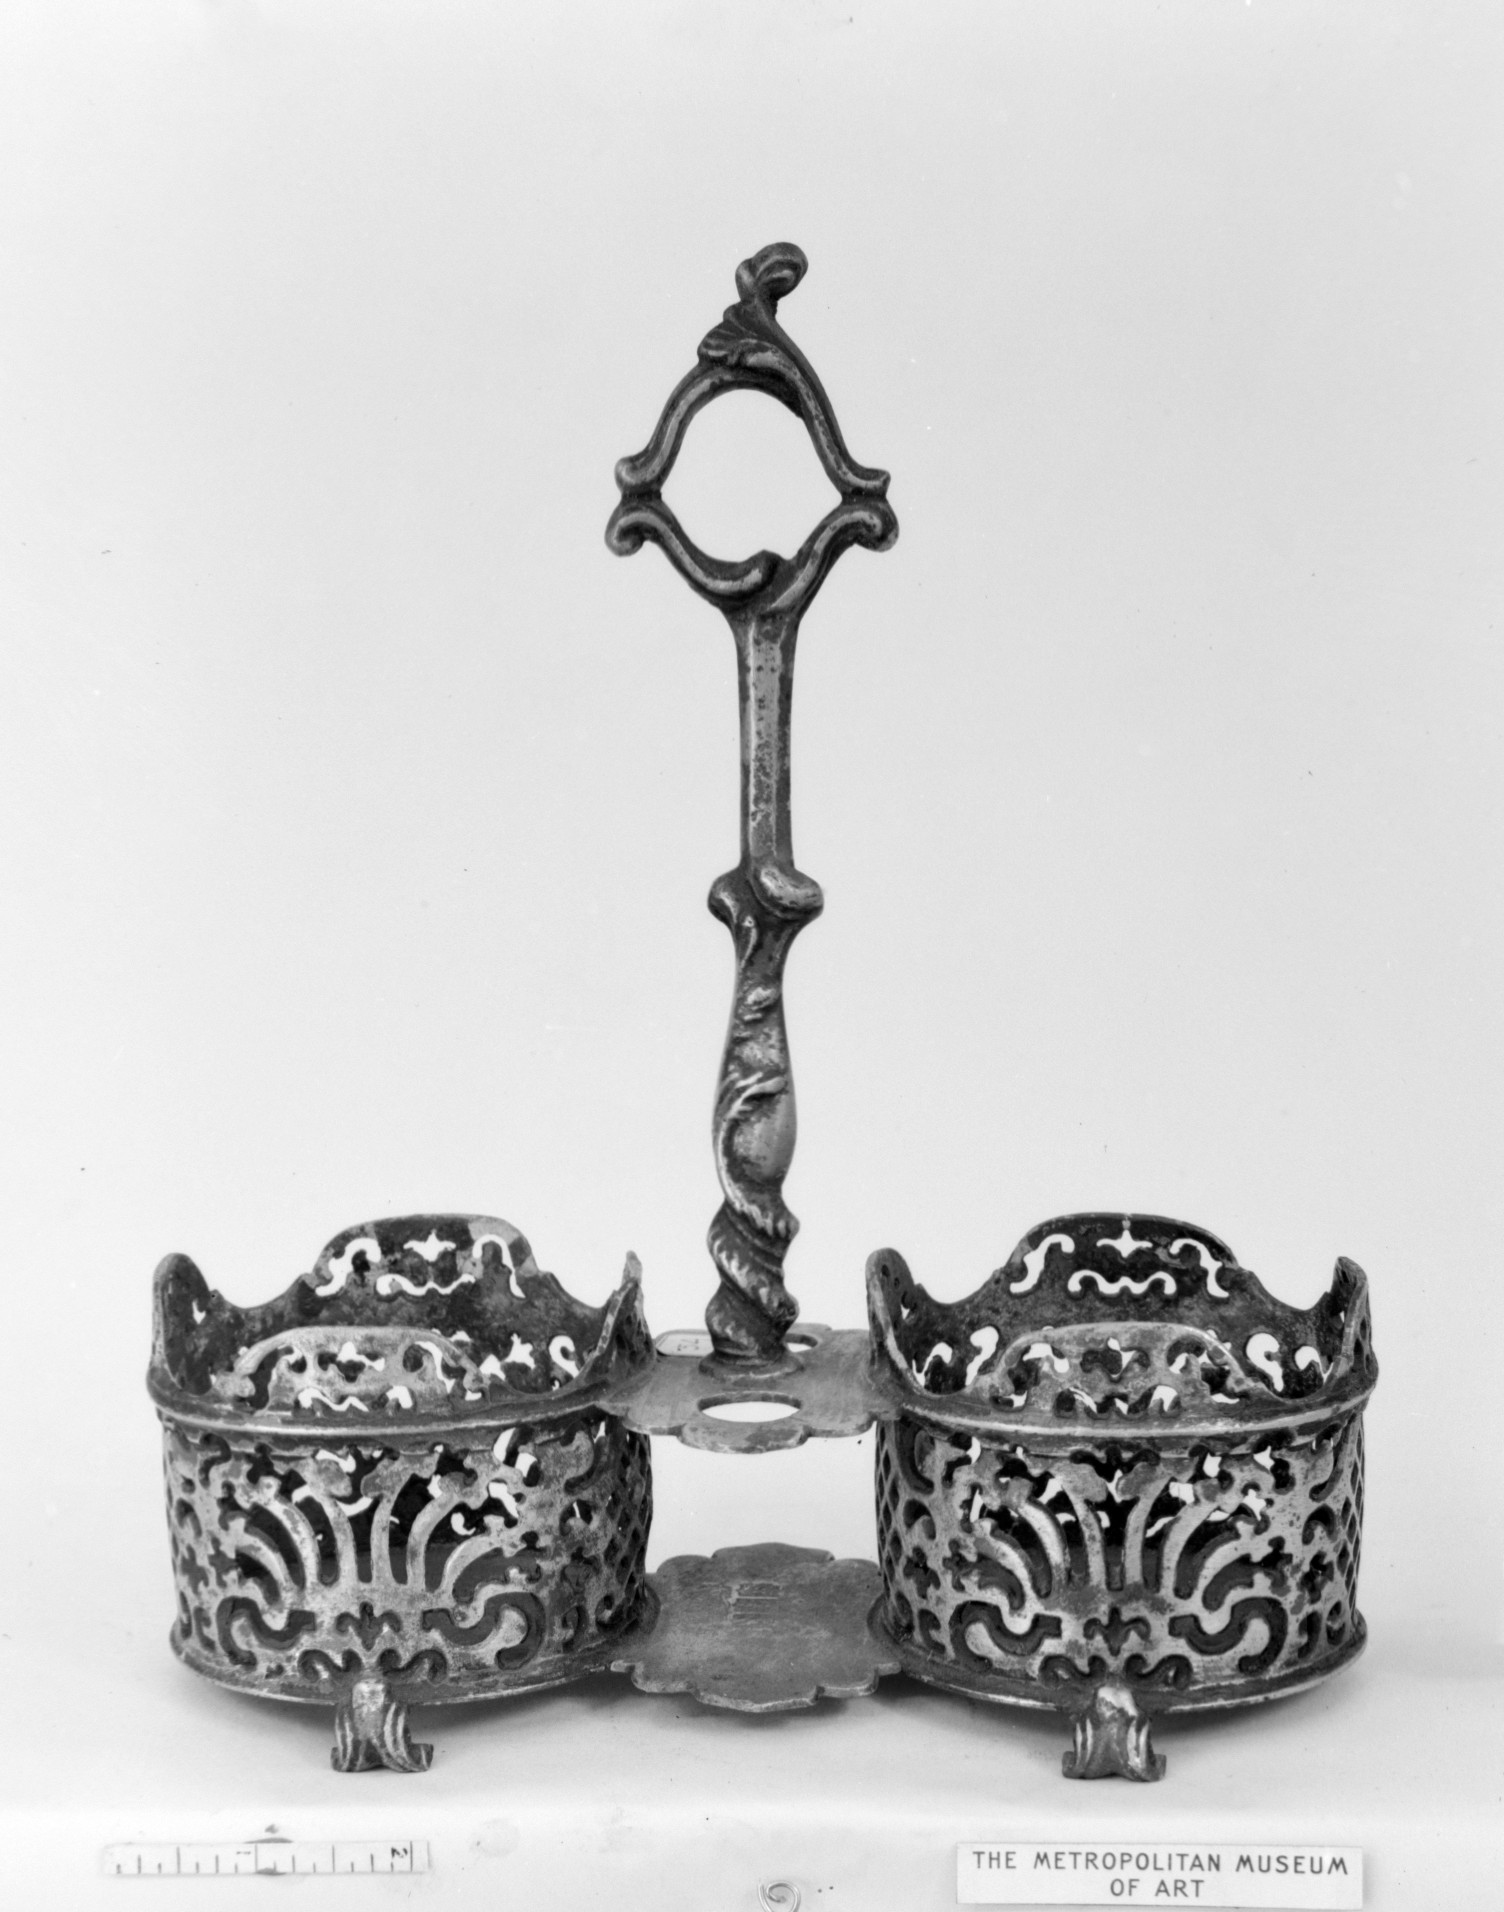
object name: cruet stand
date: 1701-1800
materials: pewter